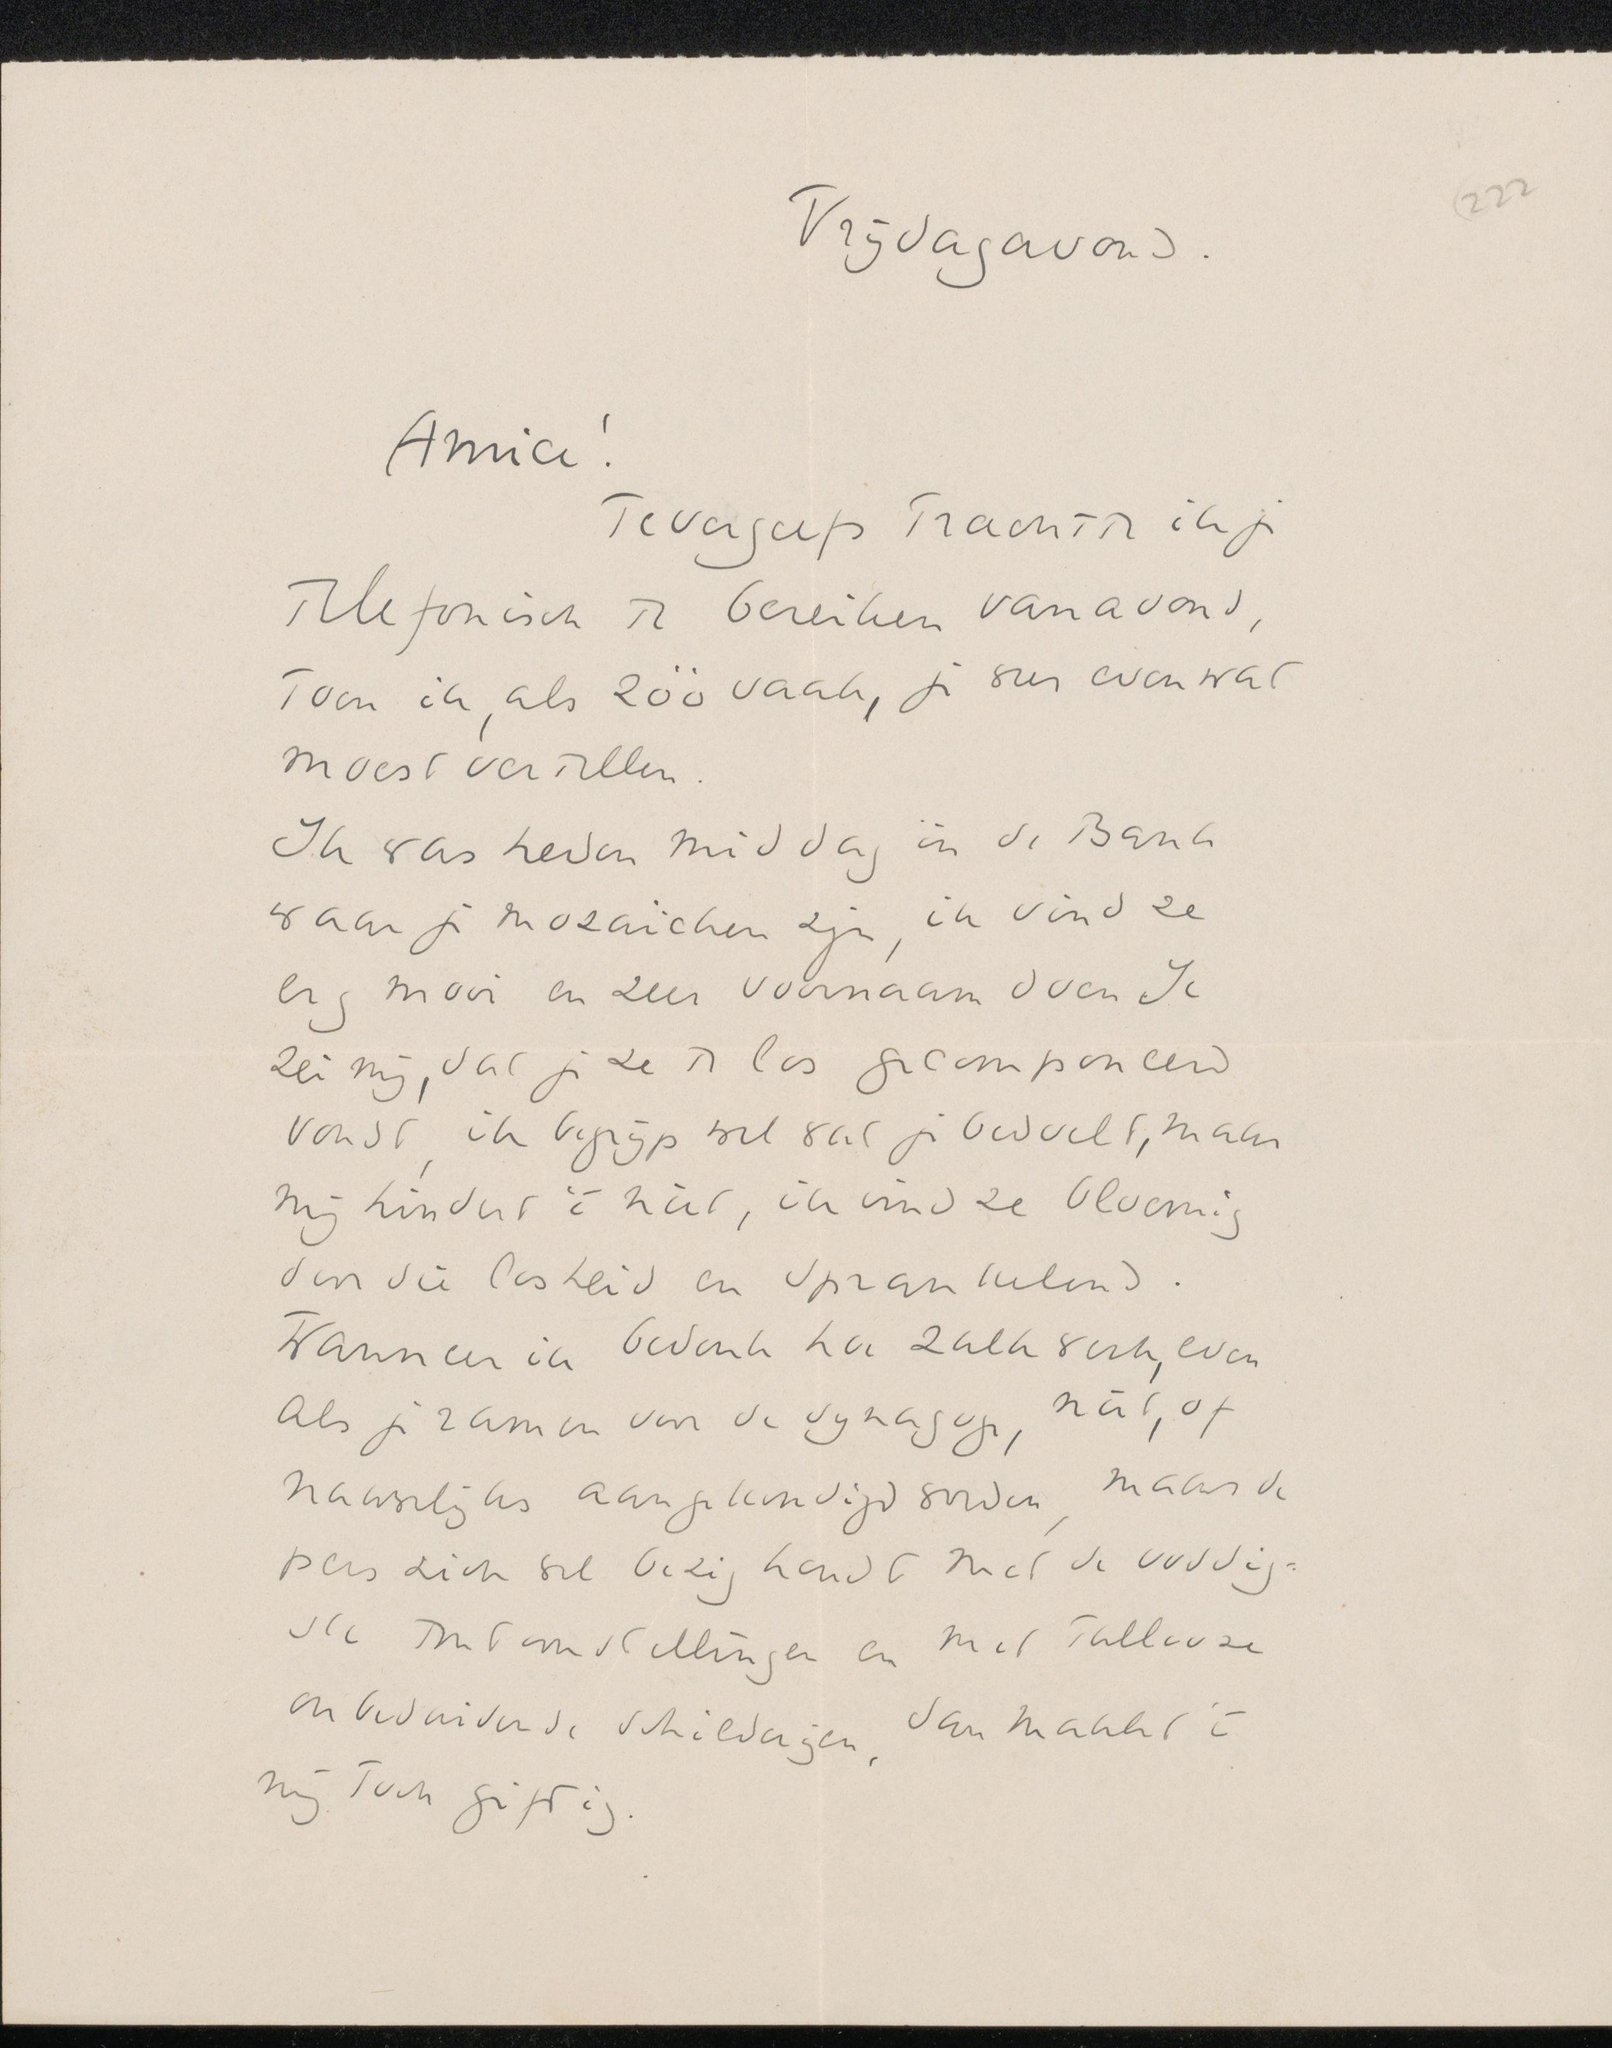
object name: letter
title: Brief aan Willem Bogtman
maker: richard nicolaüs roland holst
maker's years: 1868-1938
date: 1892-1938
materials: ink, paper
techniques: pen, writing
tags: haarlem, willem bogtman, applied arts, arts and crafts; industrial design, exhibition ~ art